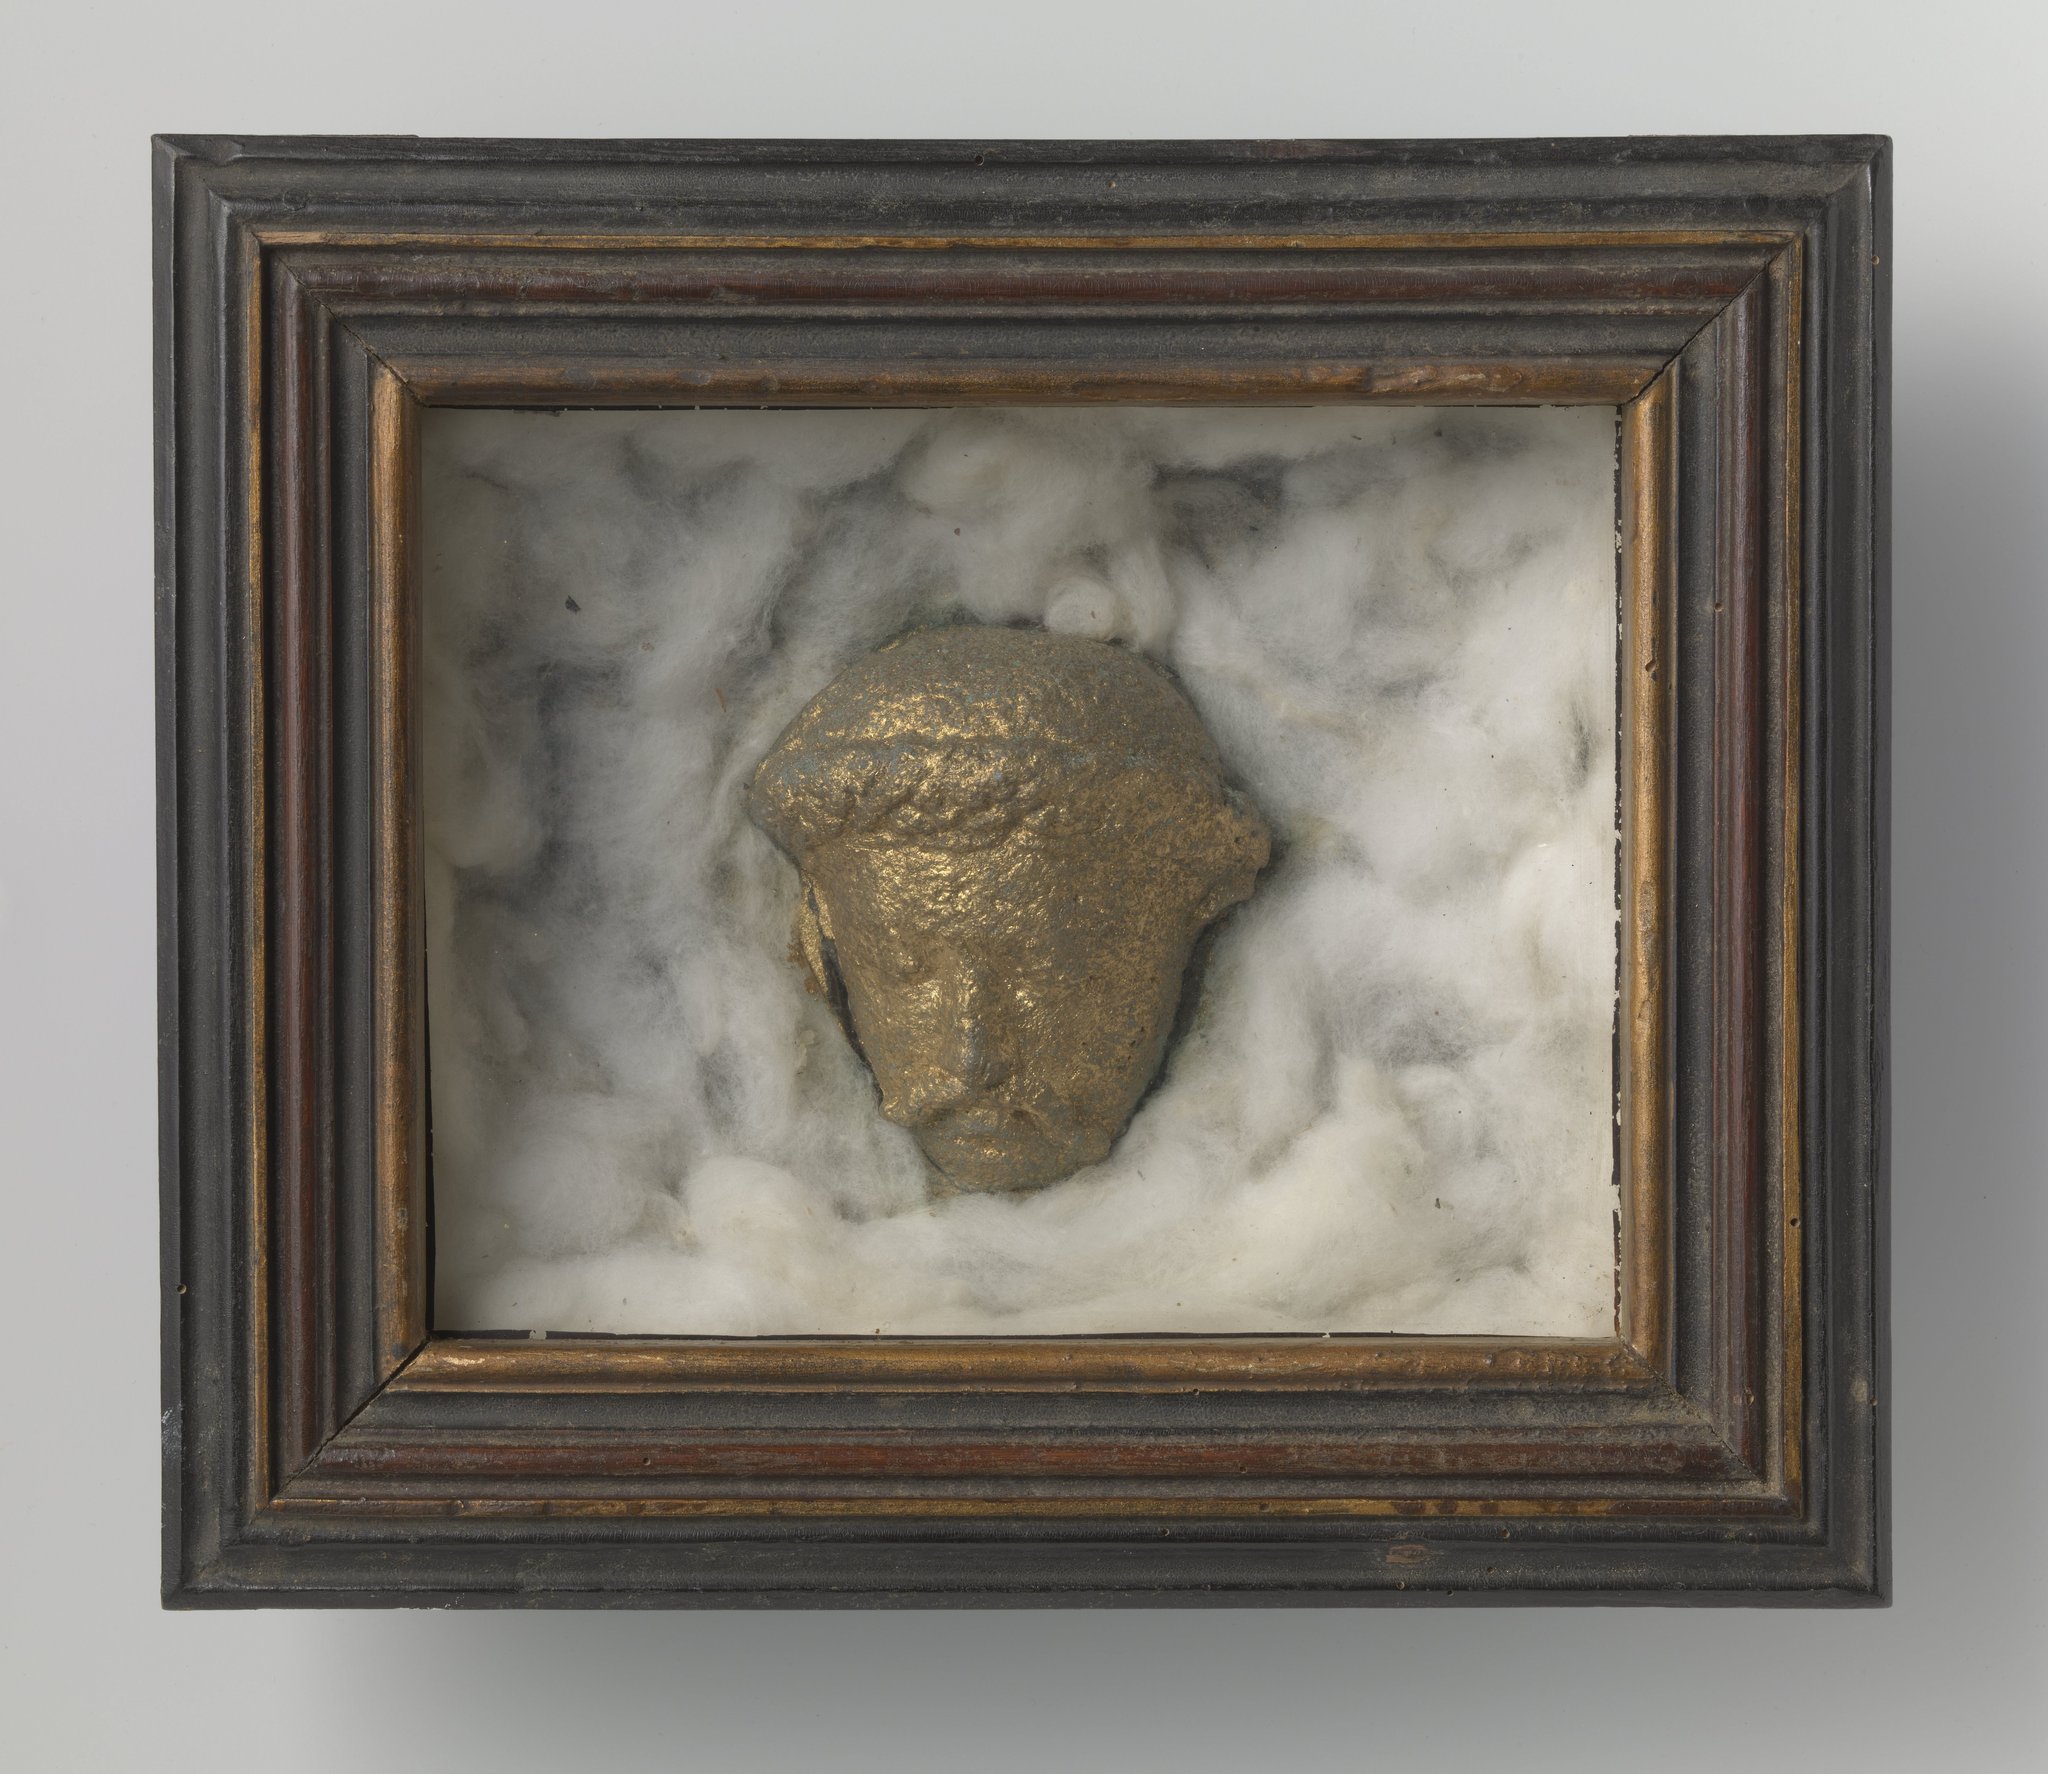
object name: sculpture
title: Stenen kopje van man met baard en snor in een kastje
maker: Anonymous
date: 800-900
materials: glass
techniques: gilding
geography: central java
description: Stenen kopje van man met baard en snor (a) in een kastje (b). Het kopje zelf is verguld en in een met een glazen plaat afgedekt kastje gelegd. De bodem van het kastje is met een laag watten bedekt.